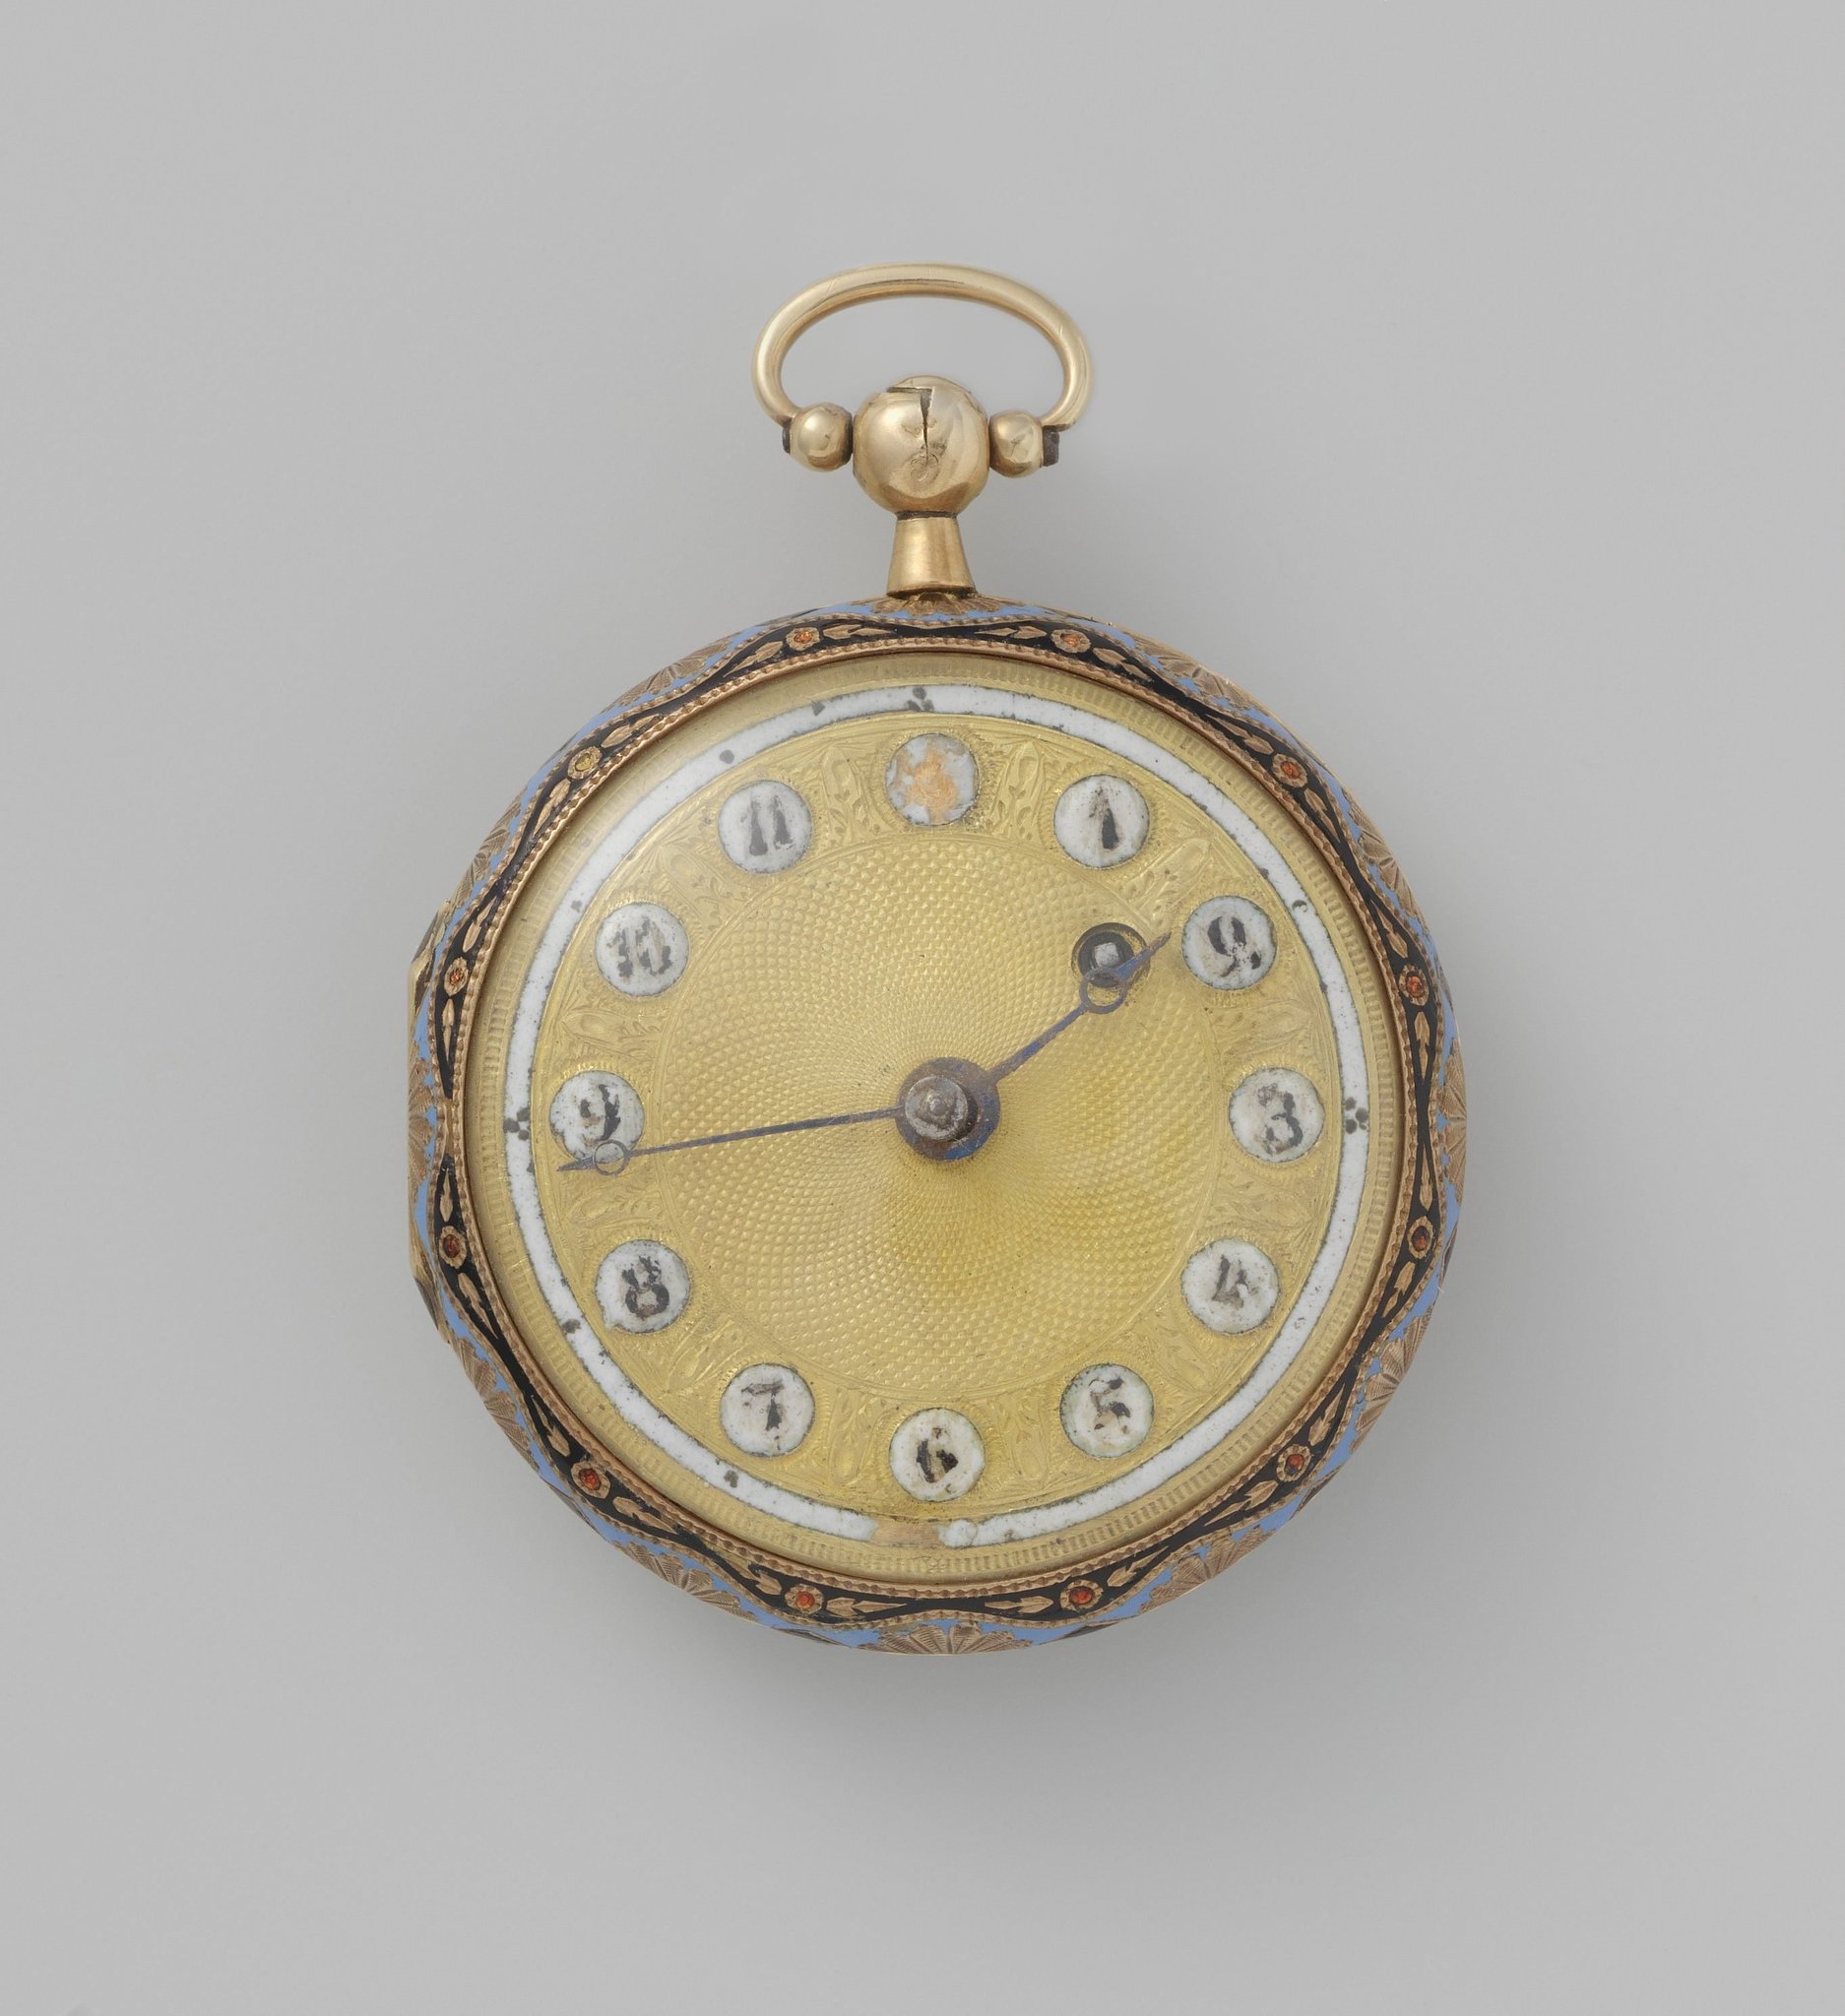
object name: jewellery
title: Watch with a Bouquet of Flowers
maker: Anonymous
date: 1830-1850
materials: gold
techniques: enameling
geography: switzerland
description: Dameshorloge van goud. Op de achterbodem een emailschildering van een bouquet. De geguillocheerde, gouden wijzerplaat is voorzien van wit geëmailleerde rondsels, waarop Arabische uurcijfers.